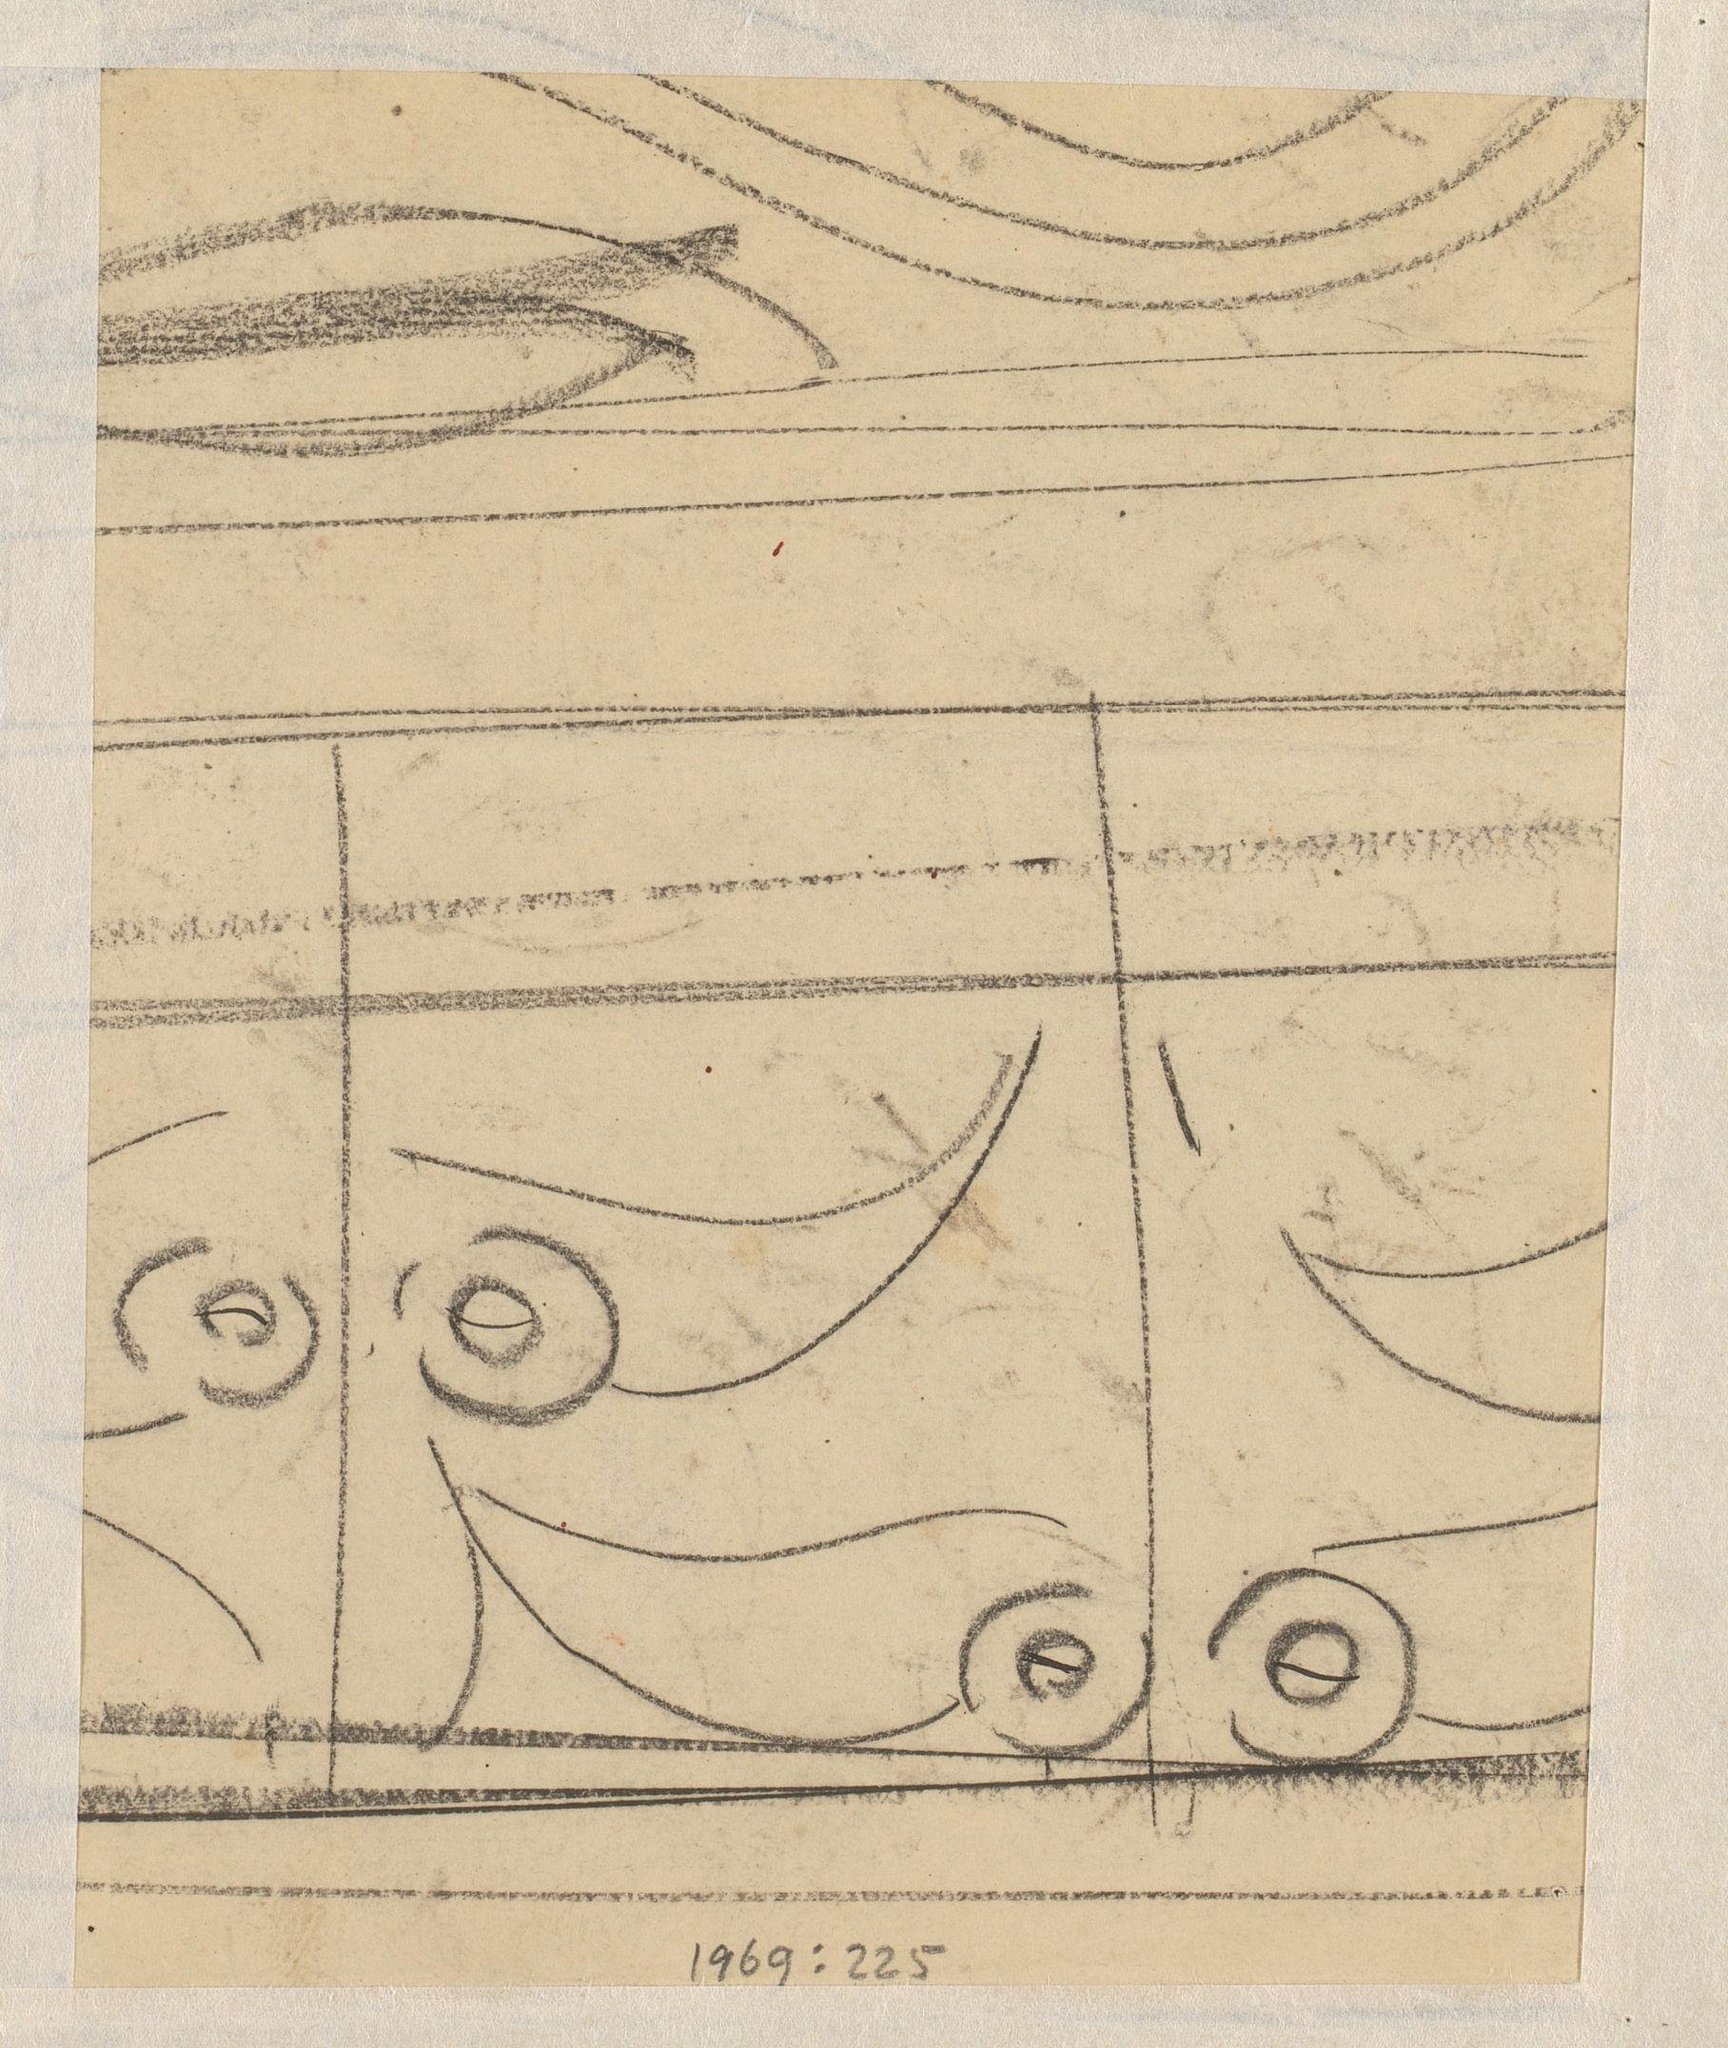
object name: drawing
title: Fragment van een ornamentstudie van een fries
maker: gerrit willem dijsselhof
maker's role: designer, draughtsman, print maker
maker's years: 1866-1924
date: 1876-1924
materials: chalk, paper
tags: ornament derived from plant forms